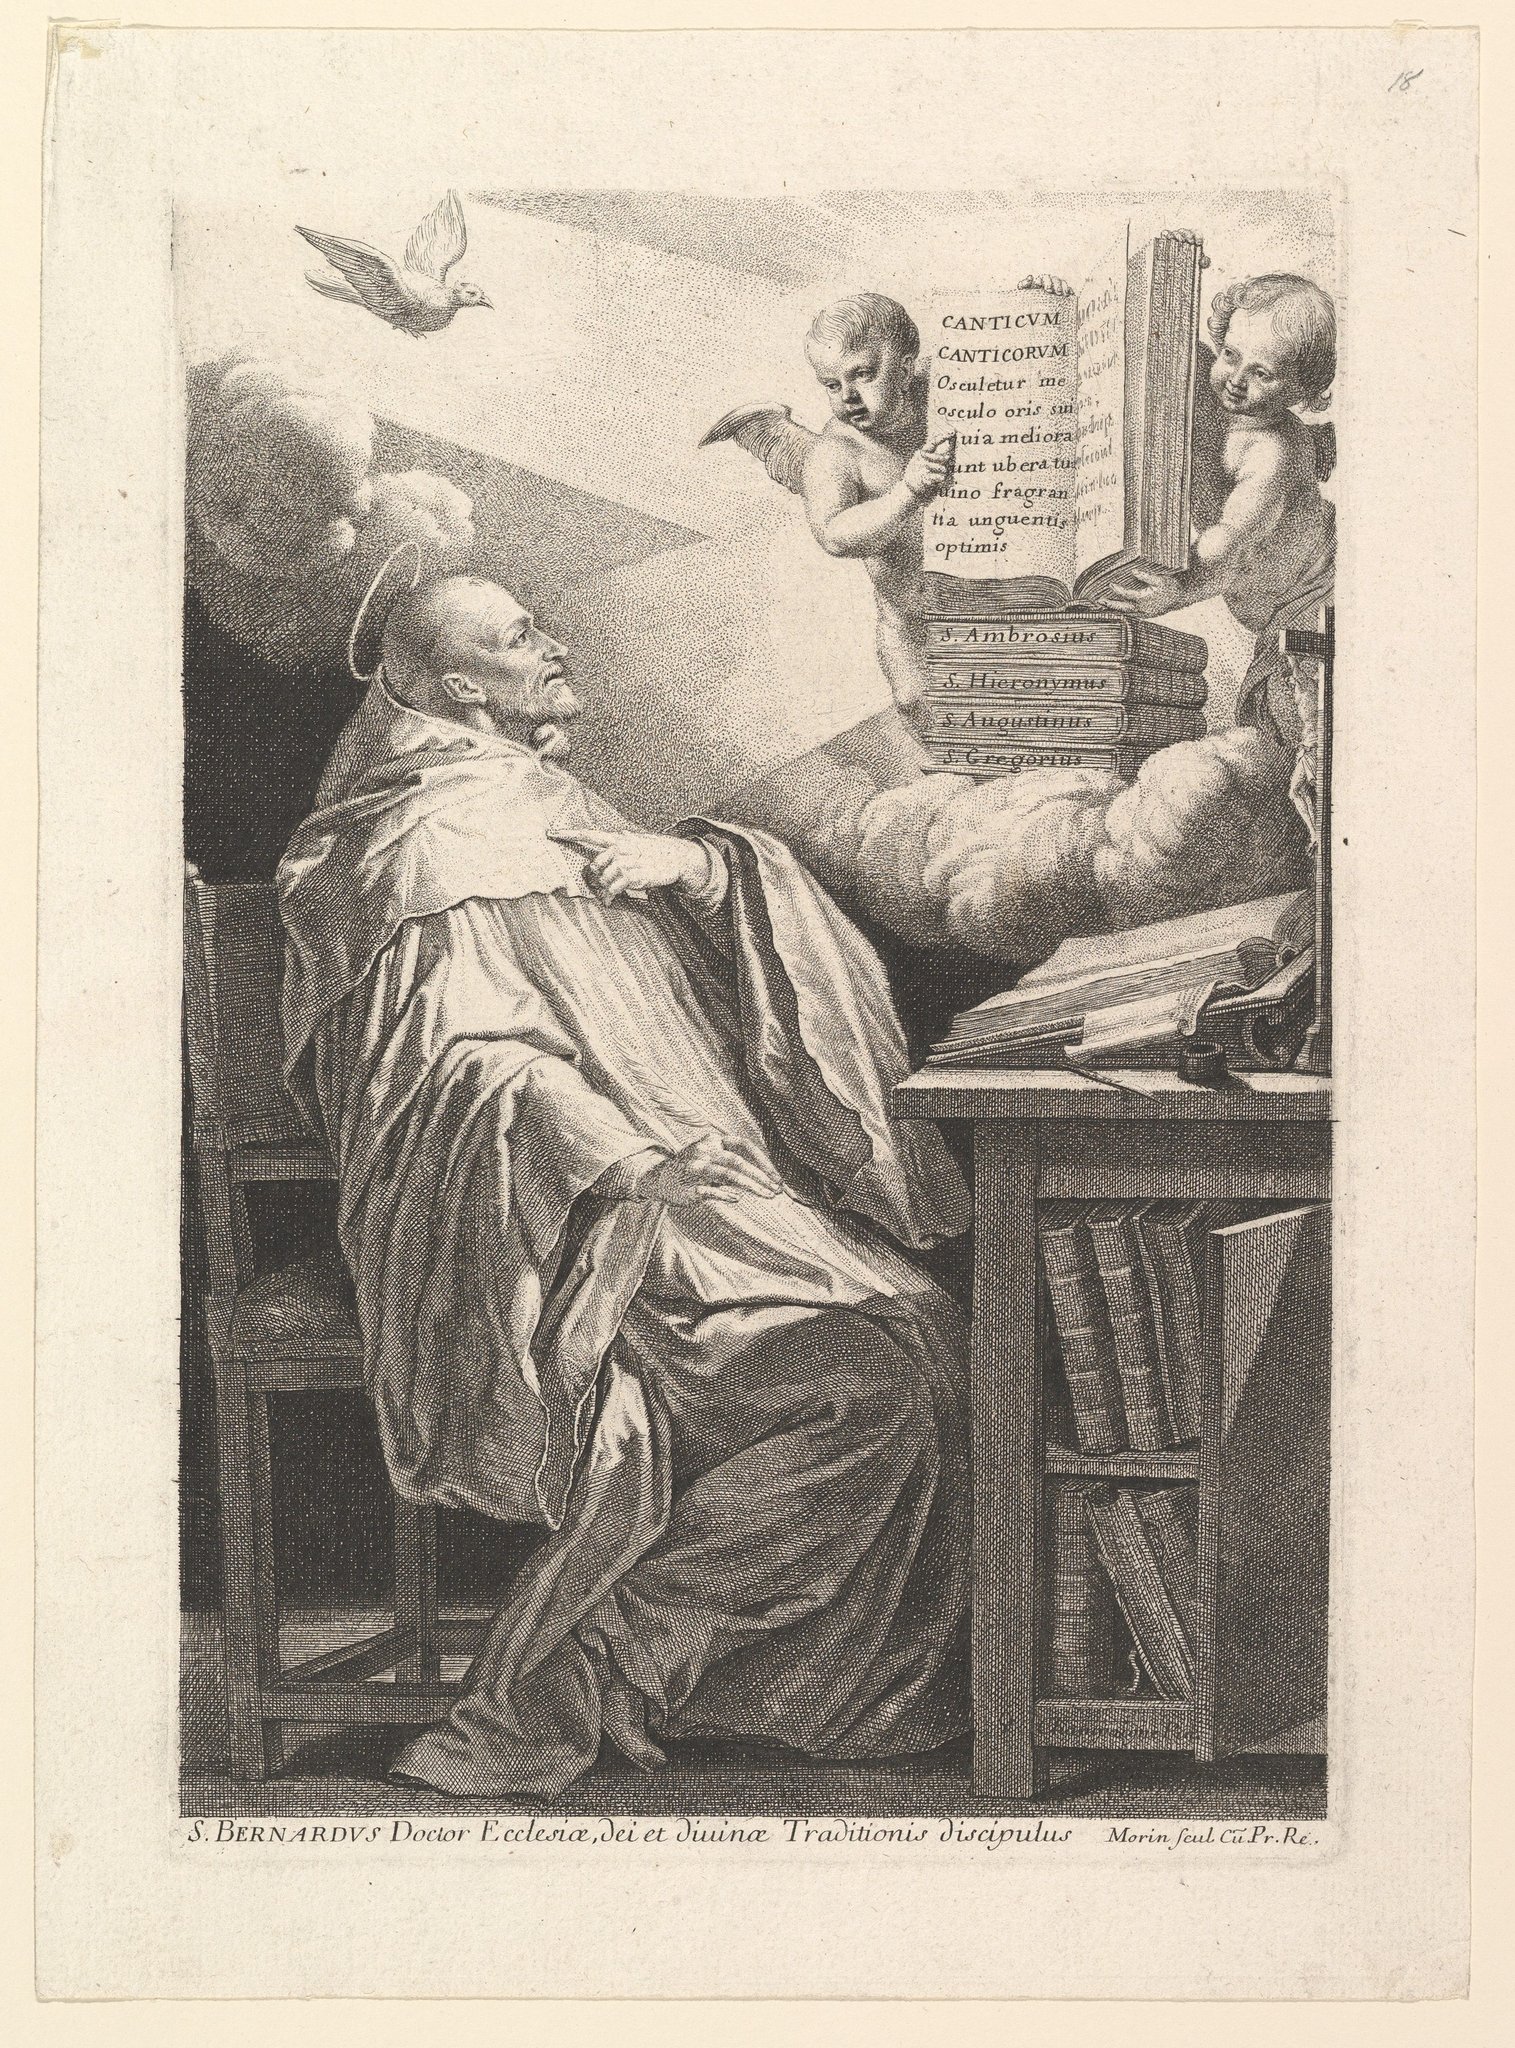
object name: print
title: Le petit saint Bernard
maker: jean morin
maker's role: artist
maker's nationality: french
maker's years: 1605-1650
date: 1605-1650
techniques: etching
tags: birds,books,saints,chairs